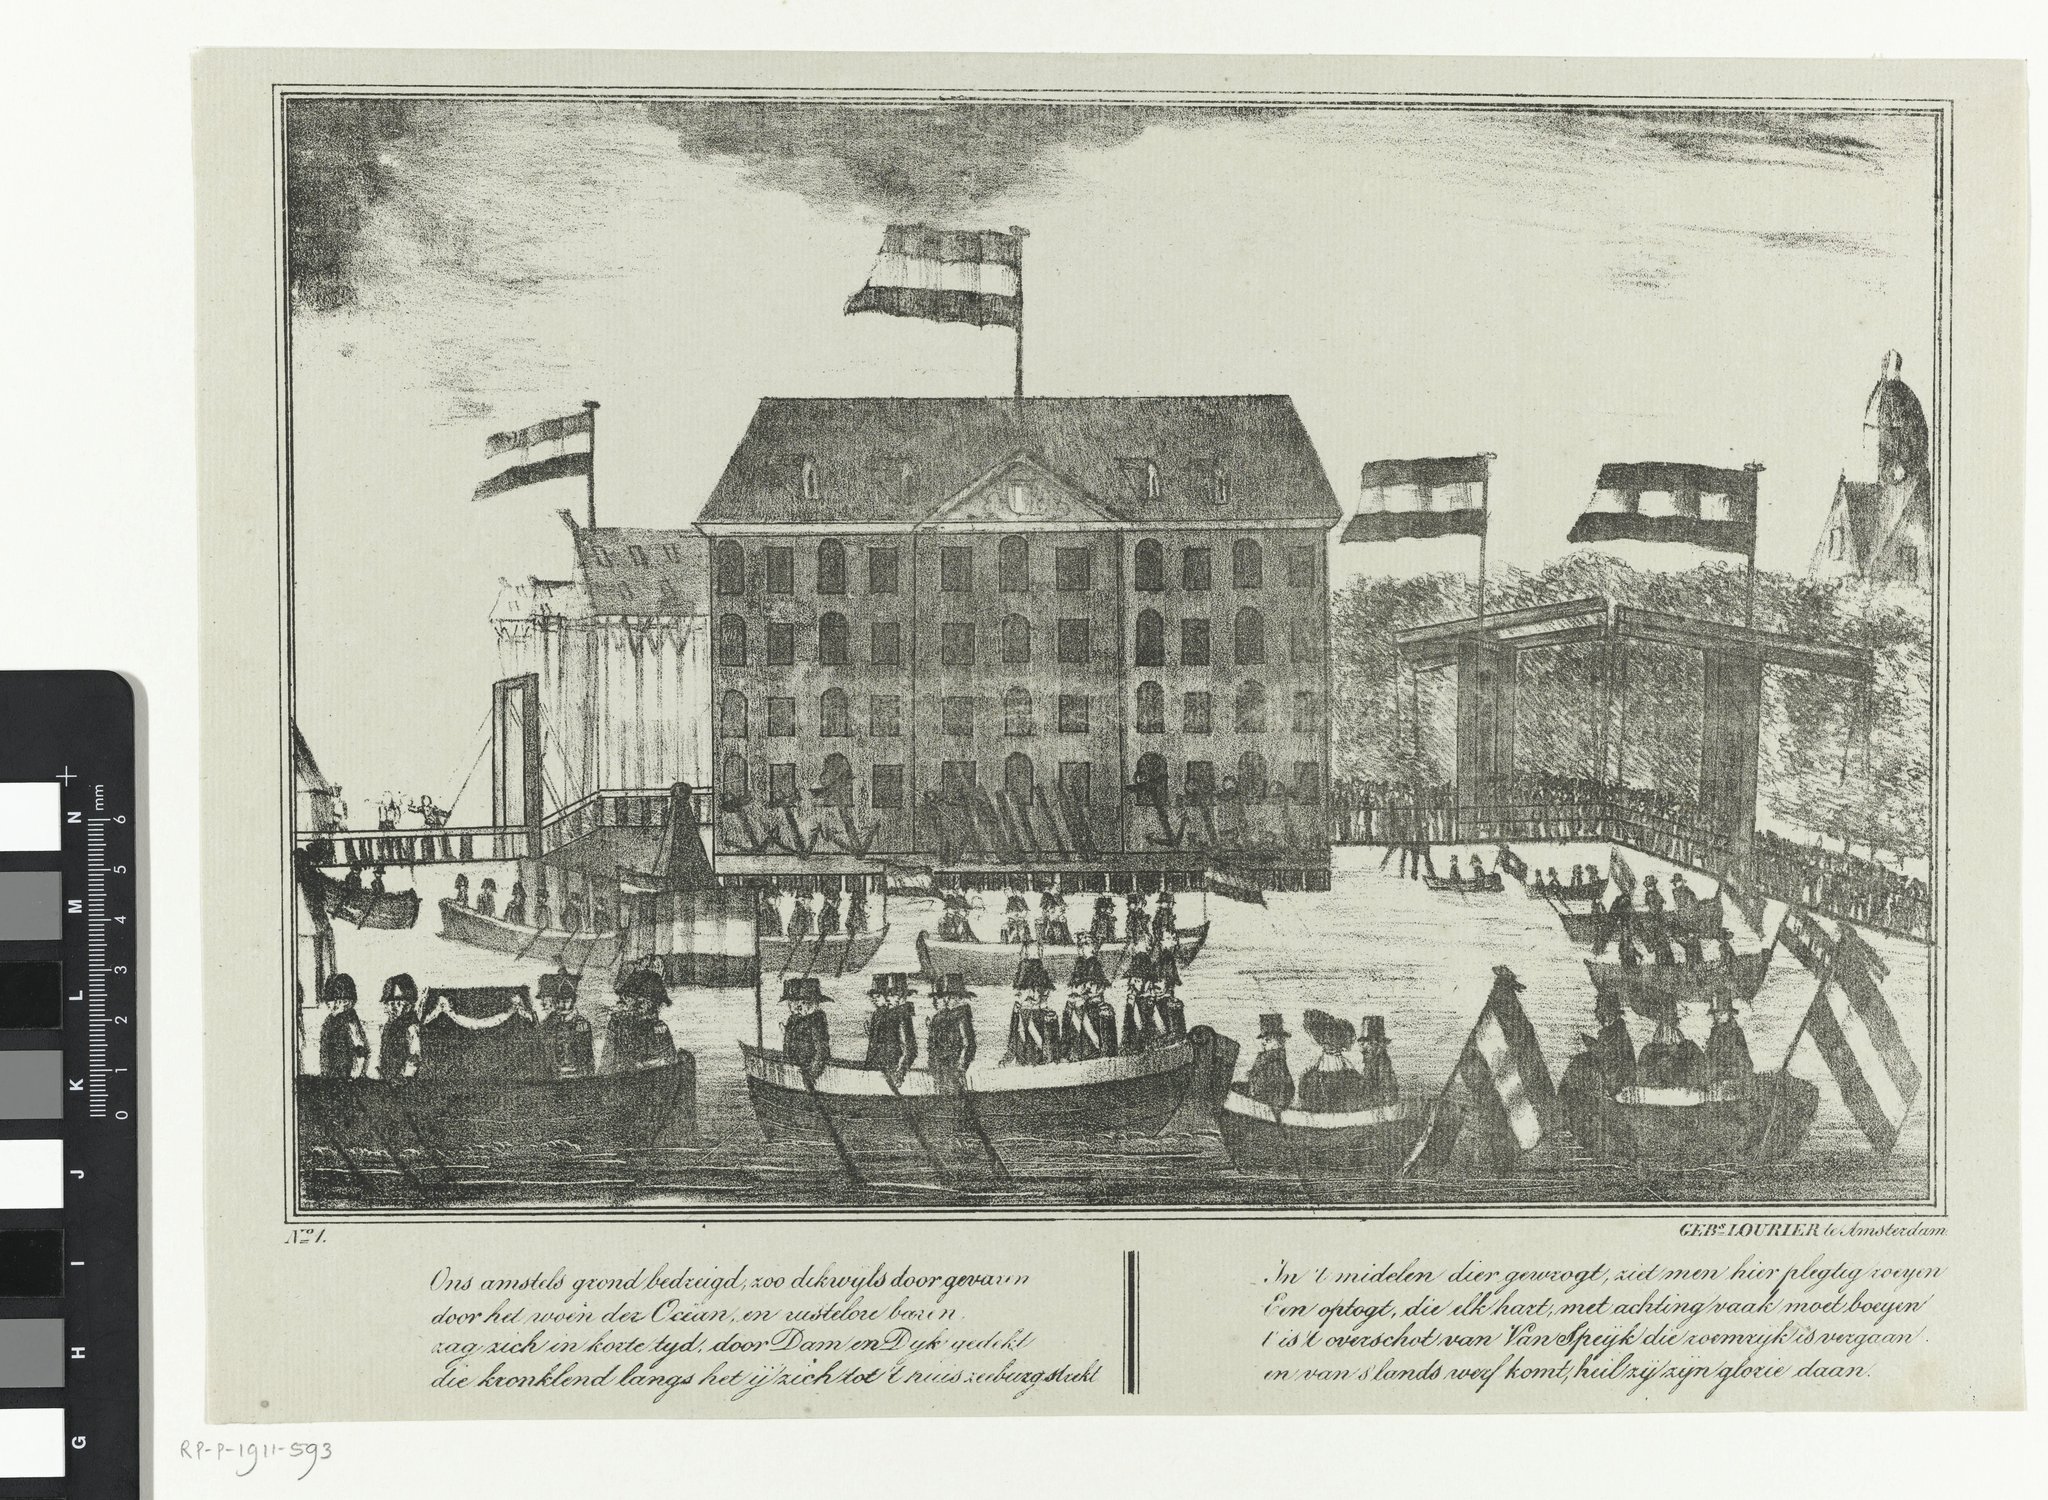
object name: print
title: Begrafenis van J.C.J. van Speyk in vier platen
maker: Anonymous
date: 1832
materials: paper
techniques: lithograph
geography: amsterdam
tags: jan van speyk, public funeral - aa - festivities on the water, cortege, funeral procession, amsterdam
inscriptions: collector's mark: Lugt 2228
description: Het begin van de lijkvaart met de stoffelijke resten van Jan van Speyk door de haven langs het gebouw van de Rijkswerf en het Magazijn der Marine. Op het water de acht kleine bootjes van de stoet en andere bootjes met toeschouwers. In het onderschrift twee vierregelige verzen. Eerste plaat in een serie van vier platen van de begrafenis van Jan van Speyk te Amsterdam op 4 met 1832.